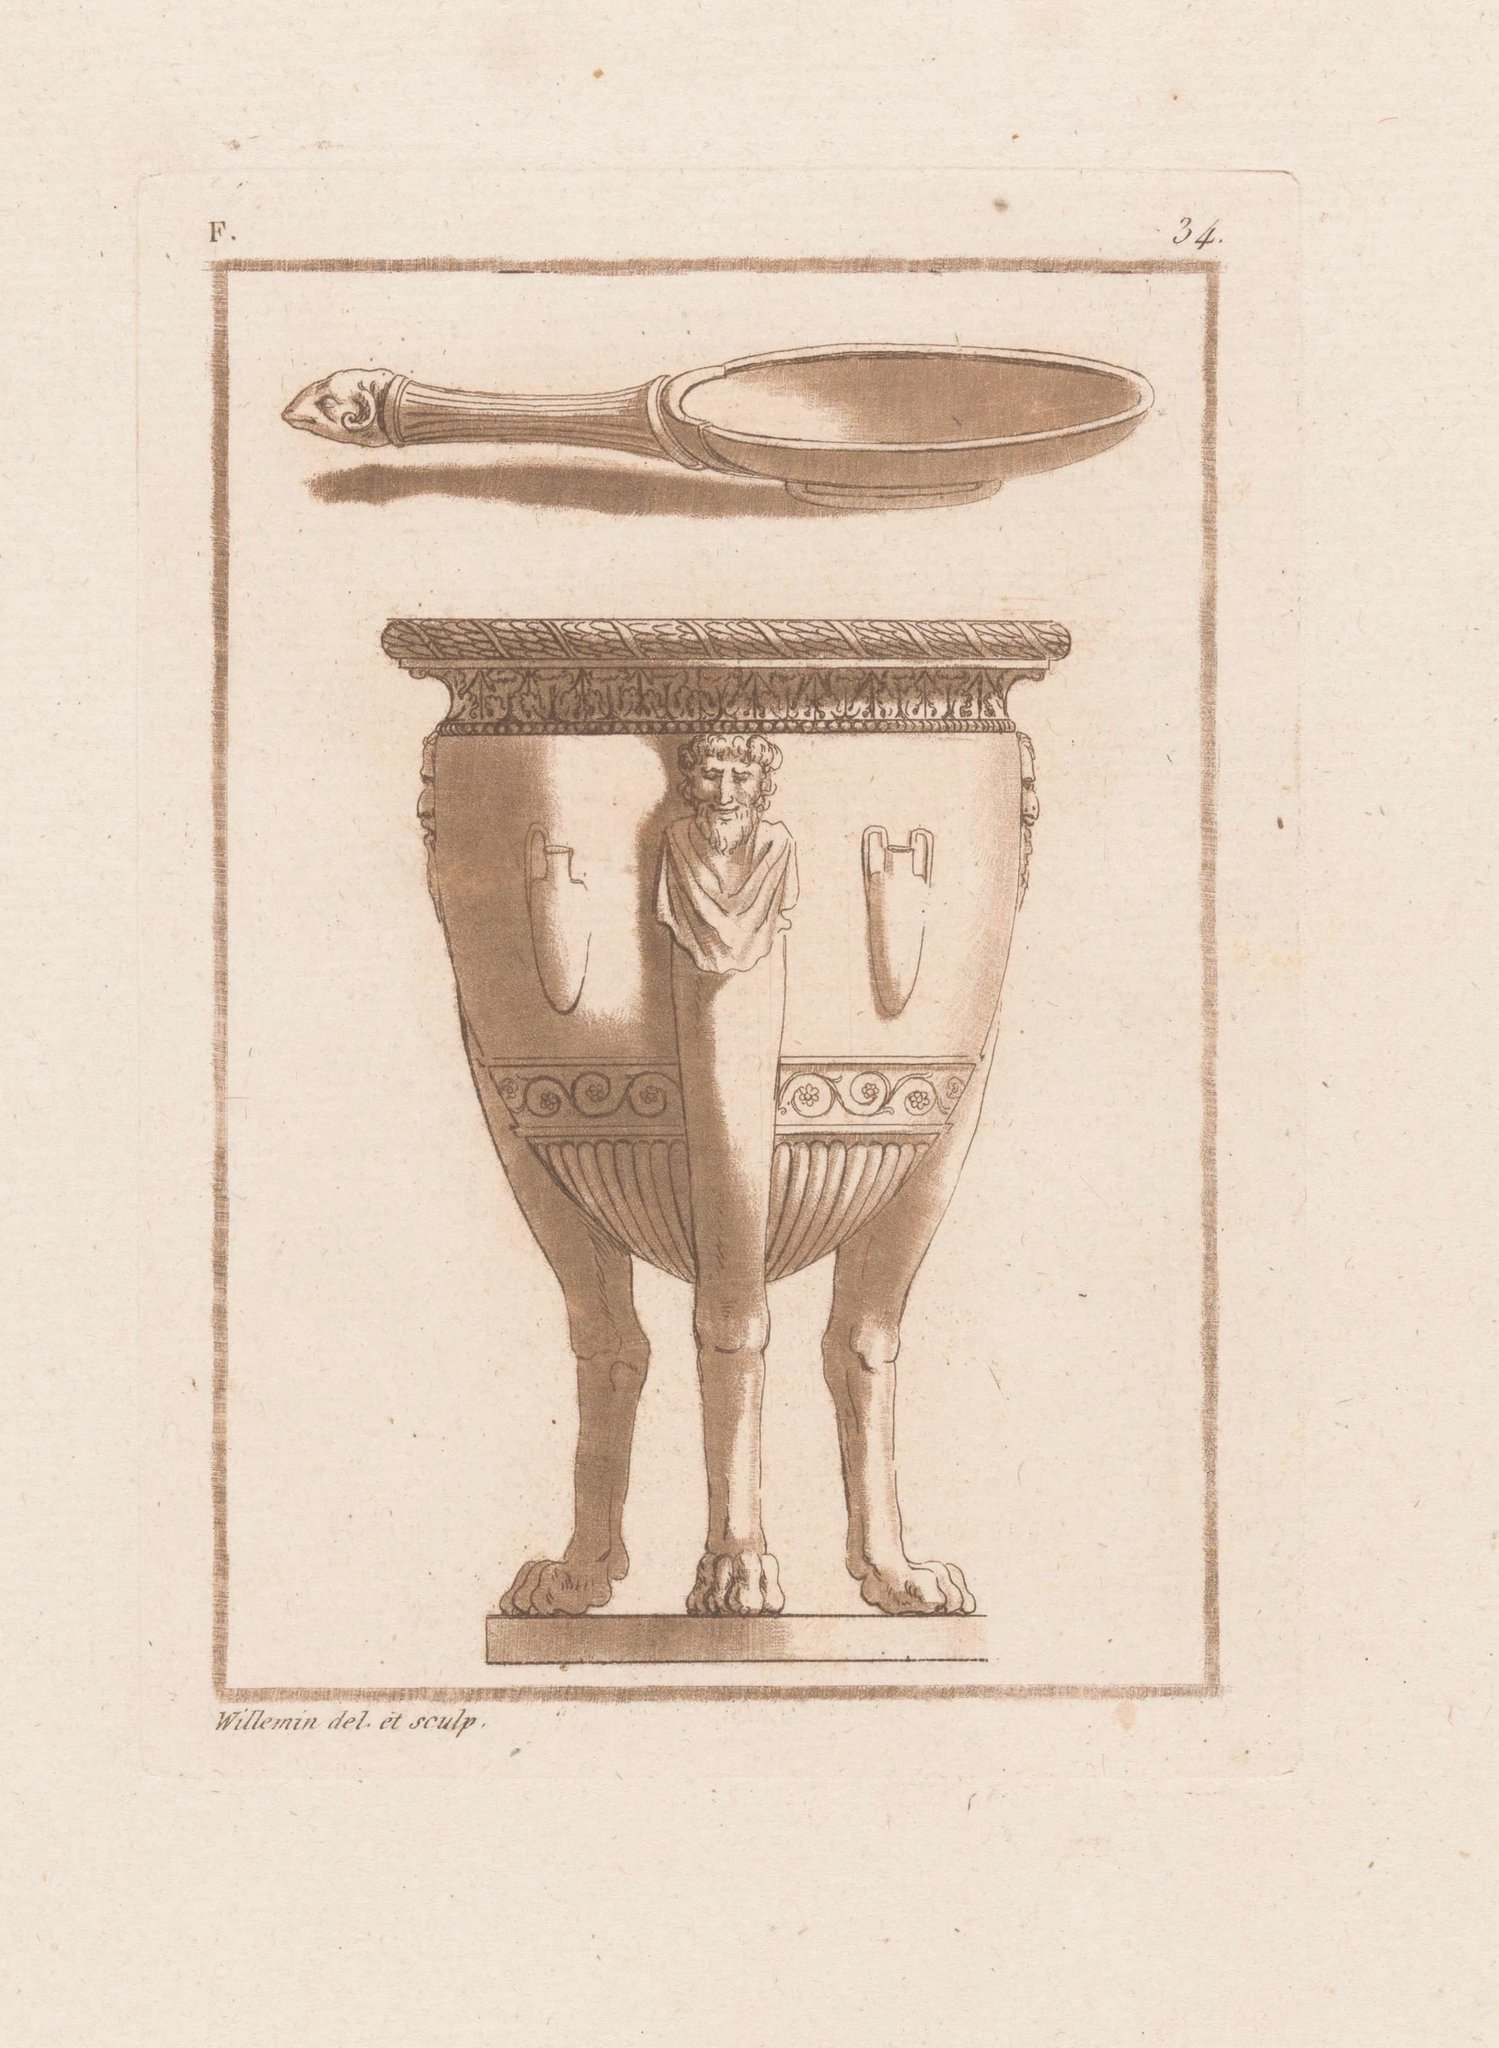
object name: print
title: Drievoet en schaal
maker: nicolas xavier willemin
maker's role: print maker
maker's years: 1763-1839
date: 1775-1797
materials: paper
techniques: aquatint, etching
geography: paris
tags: serving-dish, platter, the tripod (delphi)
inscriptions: collector's mark: Lugt 2228, collector's mark: Lugt 2760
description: Een drievoet met vazen en termen. Daarboven een schaal met handvat met ramskop.